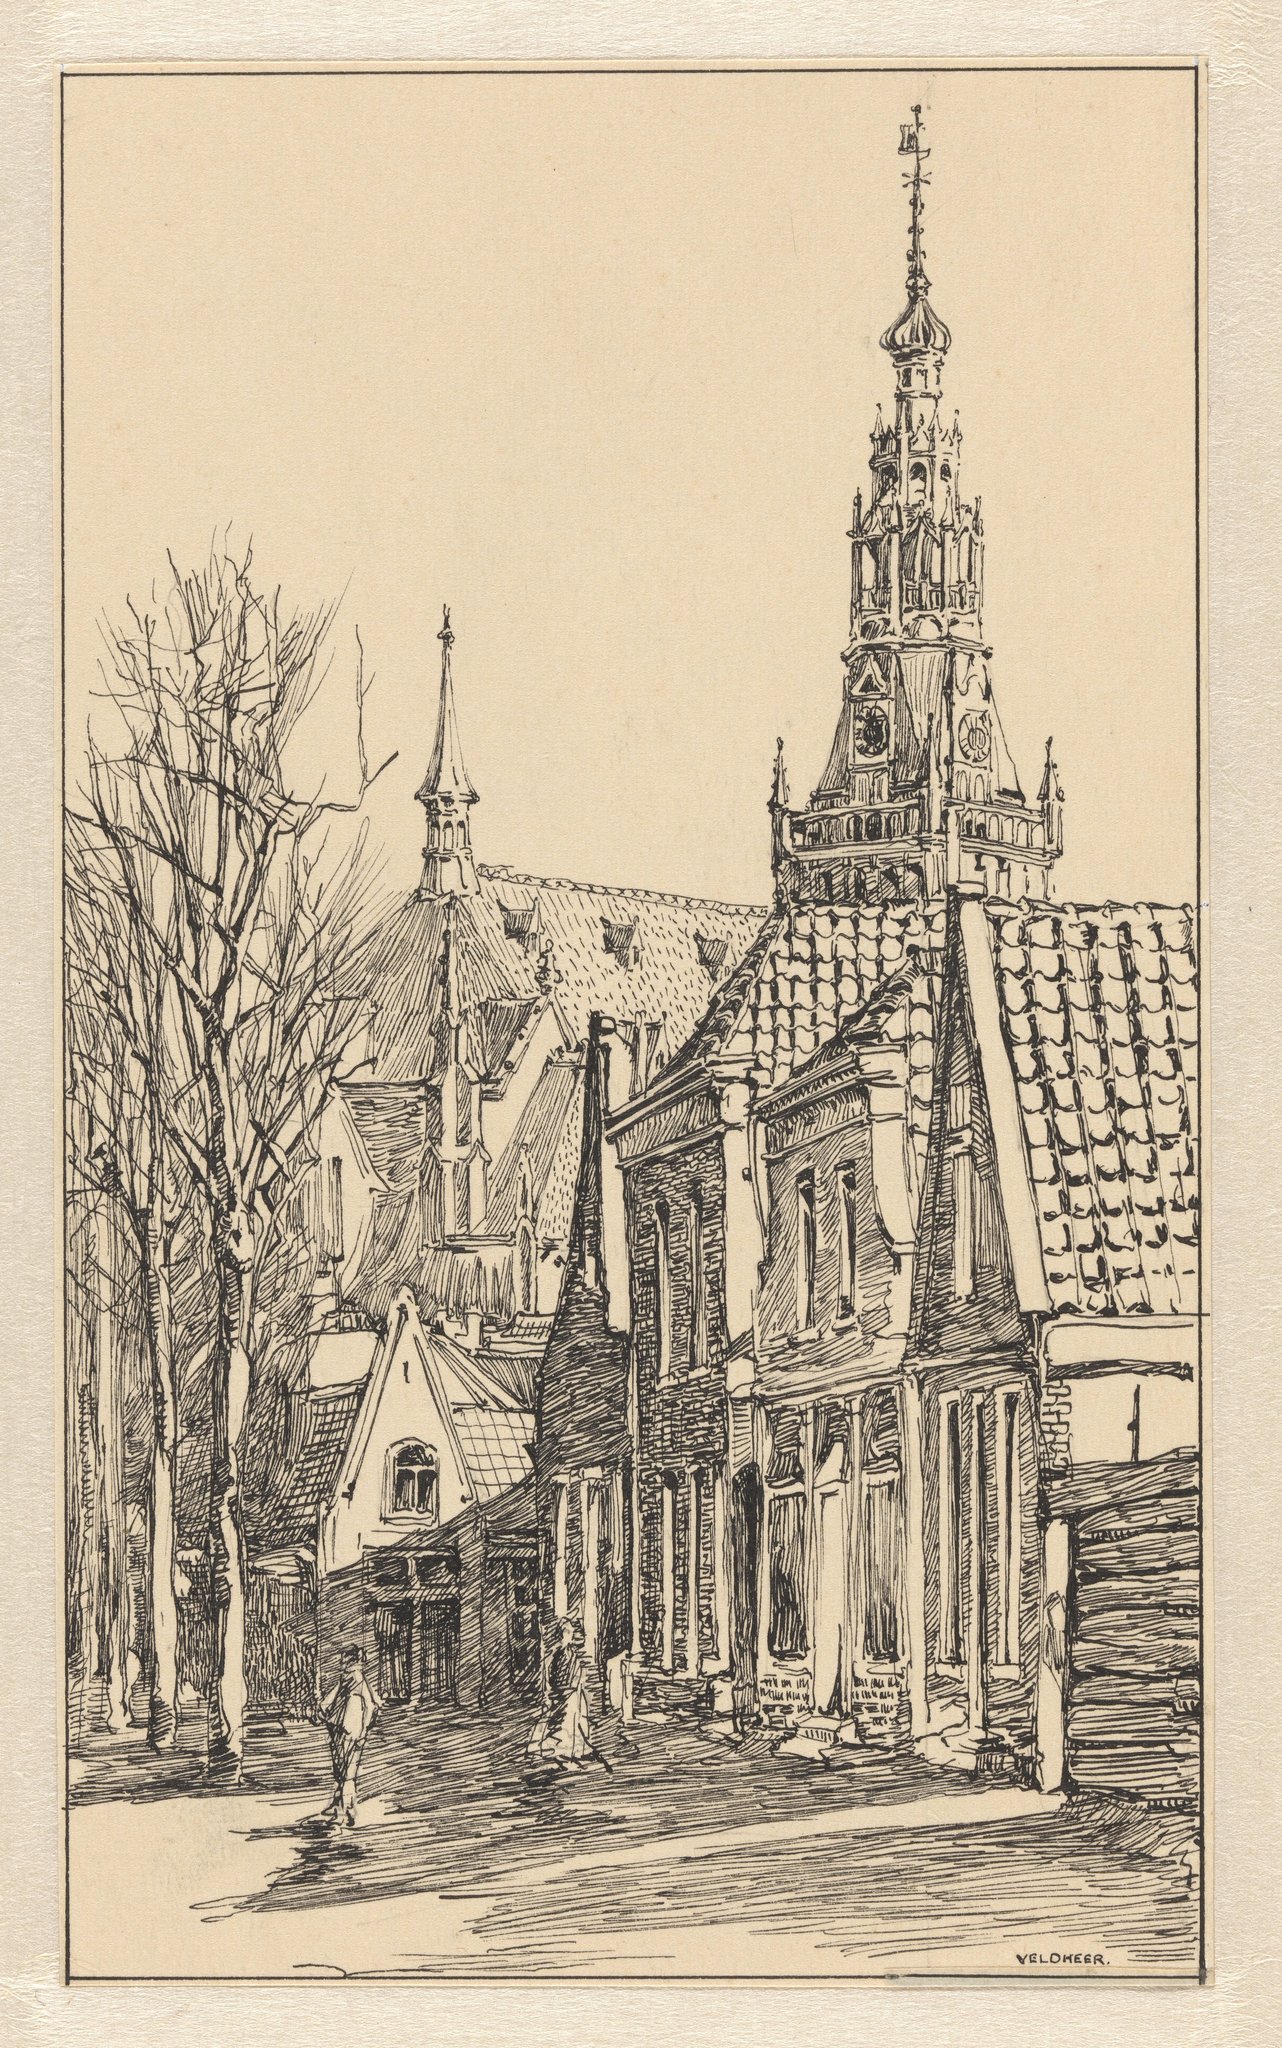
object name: drawing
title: Gezicht op de Grote Kerk te Schagen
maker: jacobus gerardus veldheer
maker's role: draughtsman, print maker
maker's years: 1866-1954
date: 1895-1903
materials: ink, paper, pencil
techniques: pen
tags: church (exterior), schagen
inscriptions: collector's mark: Lugt 2228, annotation: ‘Gezicht op de Nieuwe Kerk/ te Schagen’